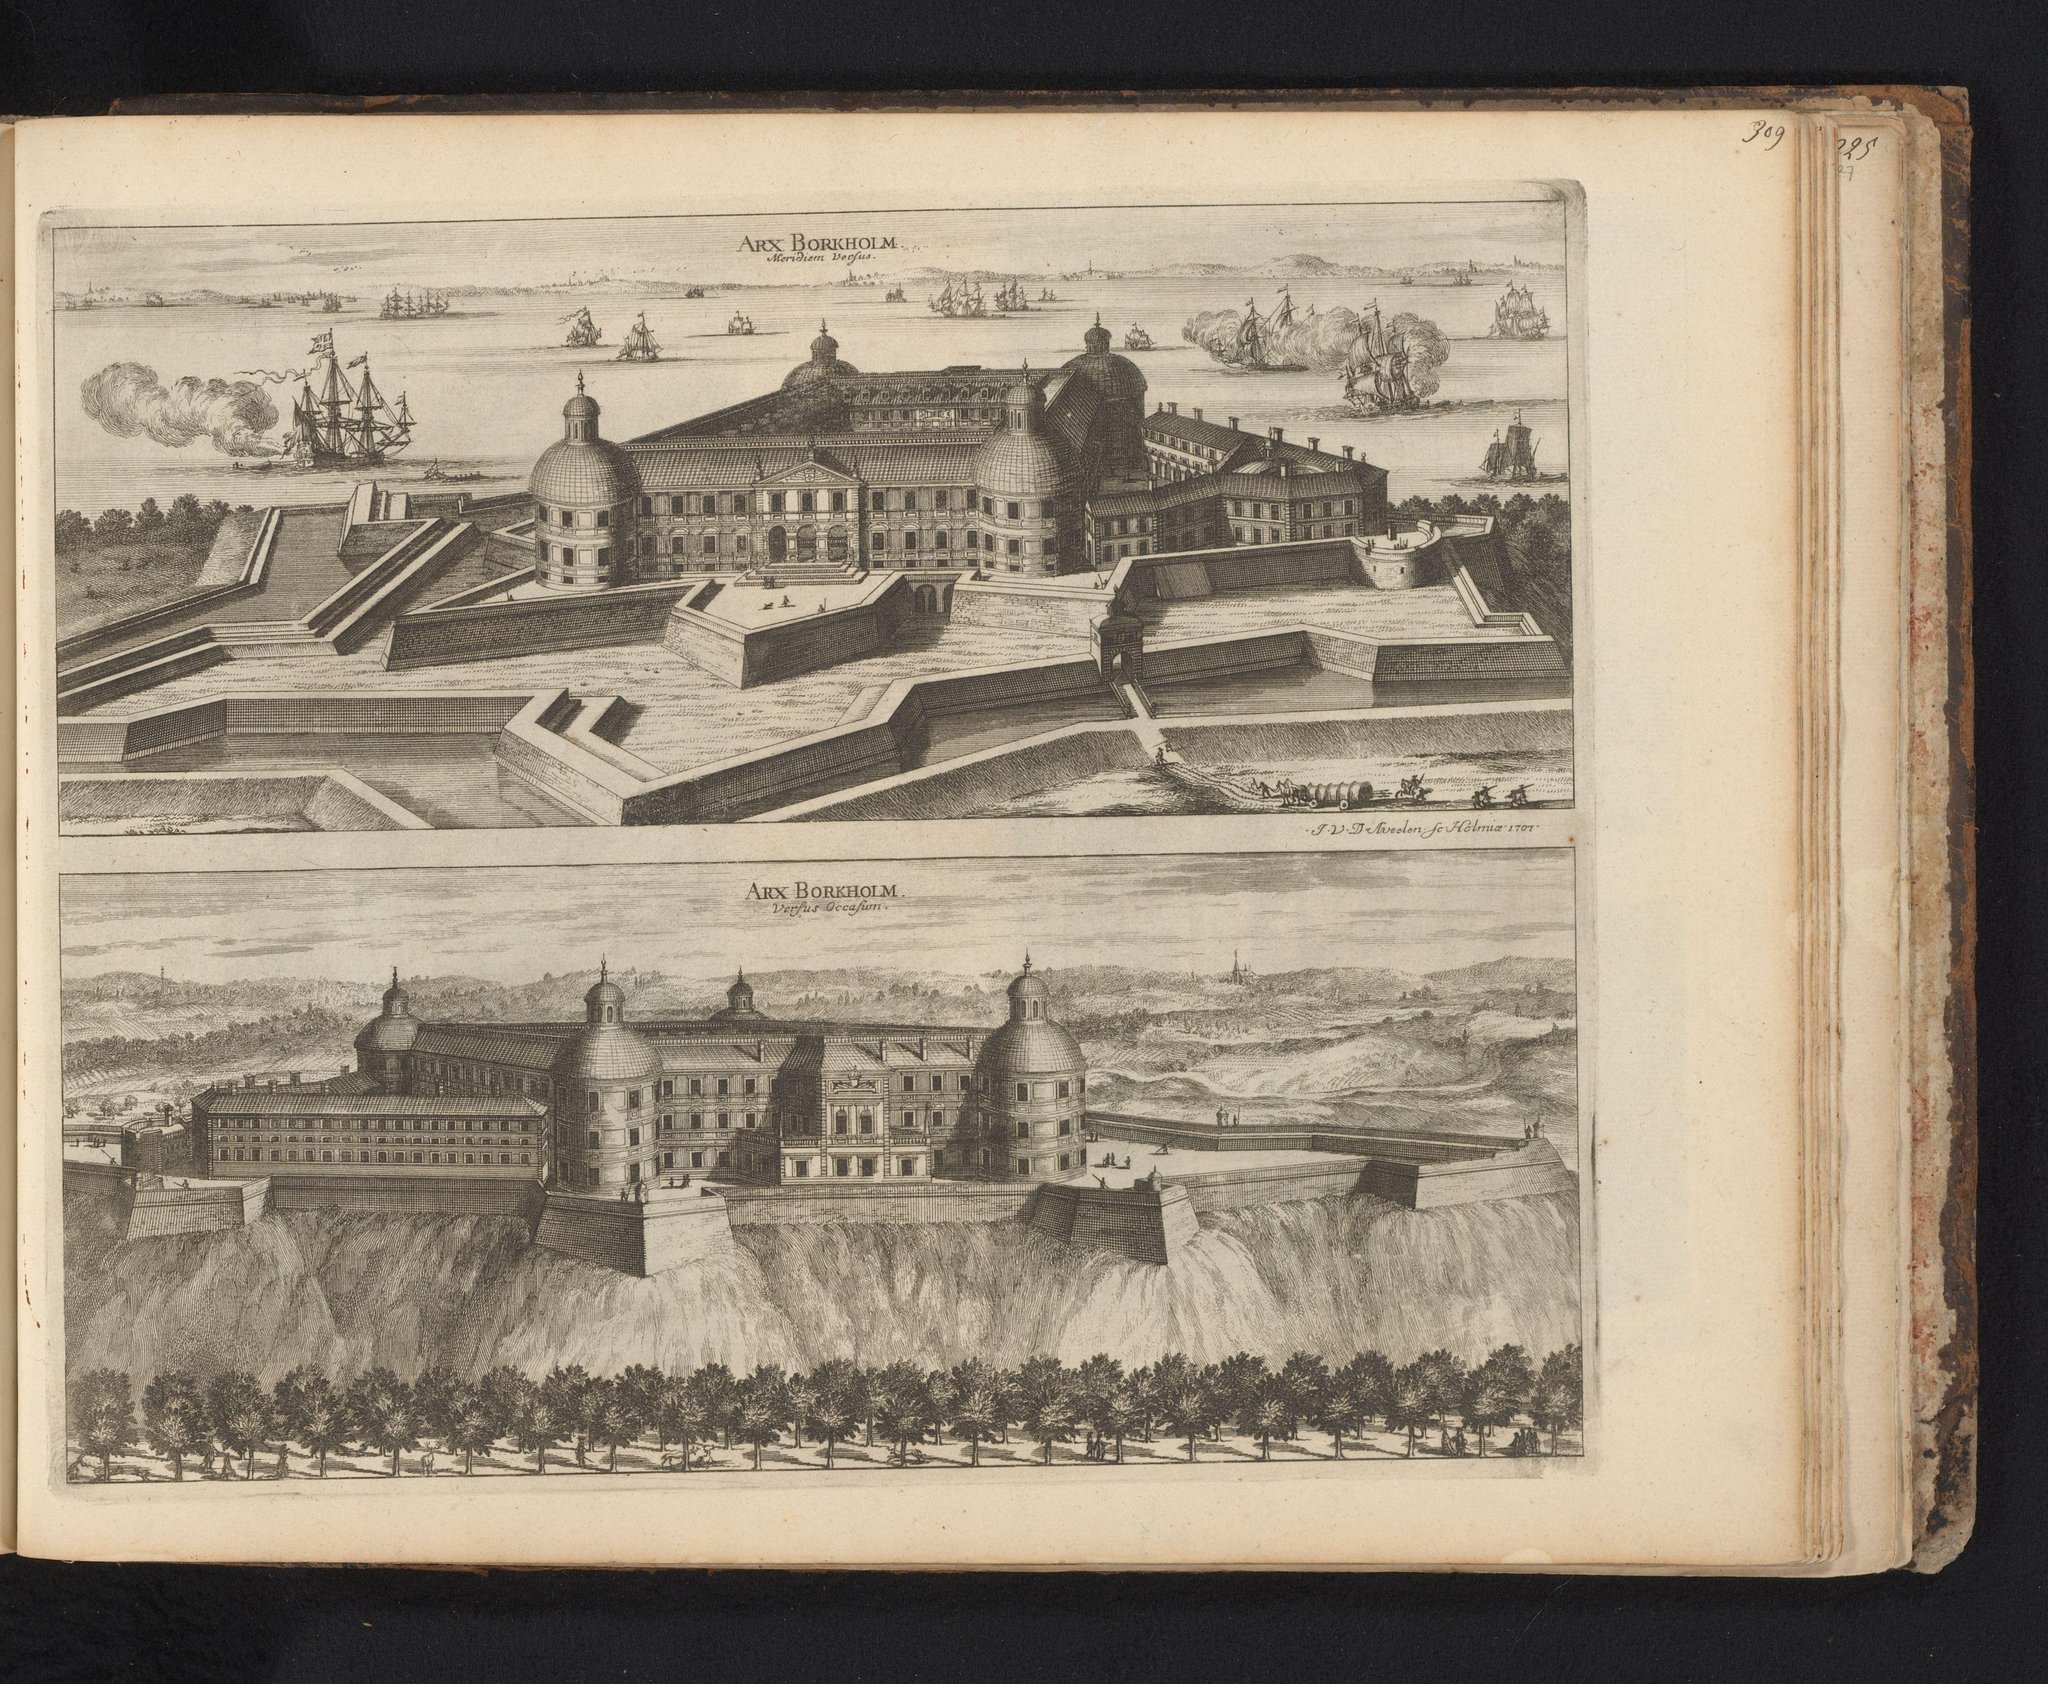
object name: album leaf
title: Suecia Antiqua et Hodierna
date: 1707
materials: paper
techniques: etching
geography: stockholm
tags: castle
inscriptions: date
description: Kungliga Biblioteket, 'Suecia': http://www.kb.se/samlingarna/Kartor-bilder/Suecia-antiqua/ (geraadpleegd november 2016).